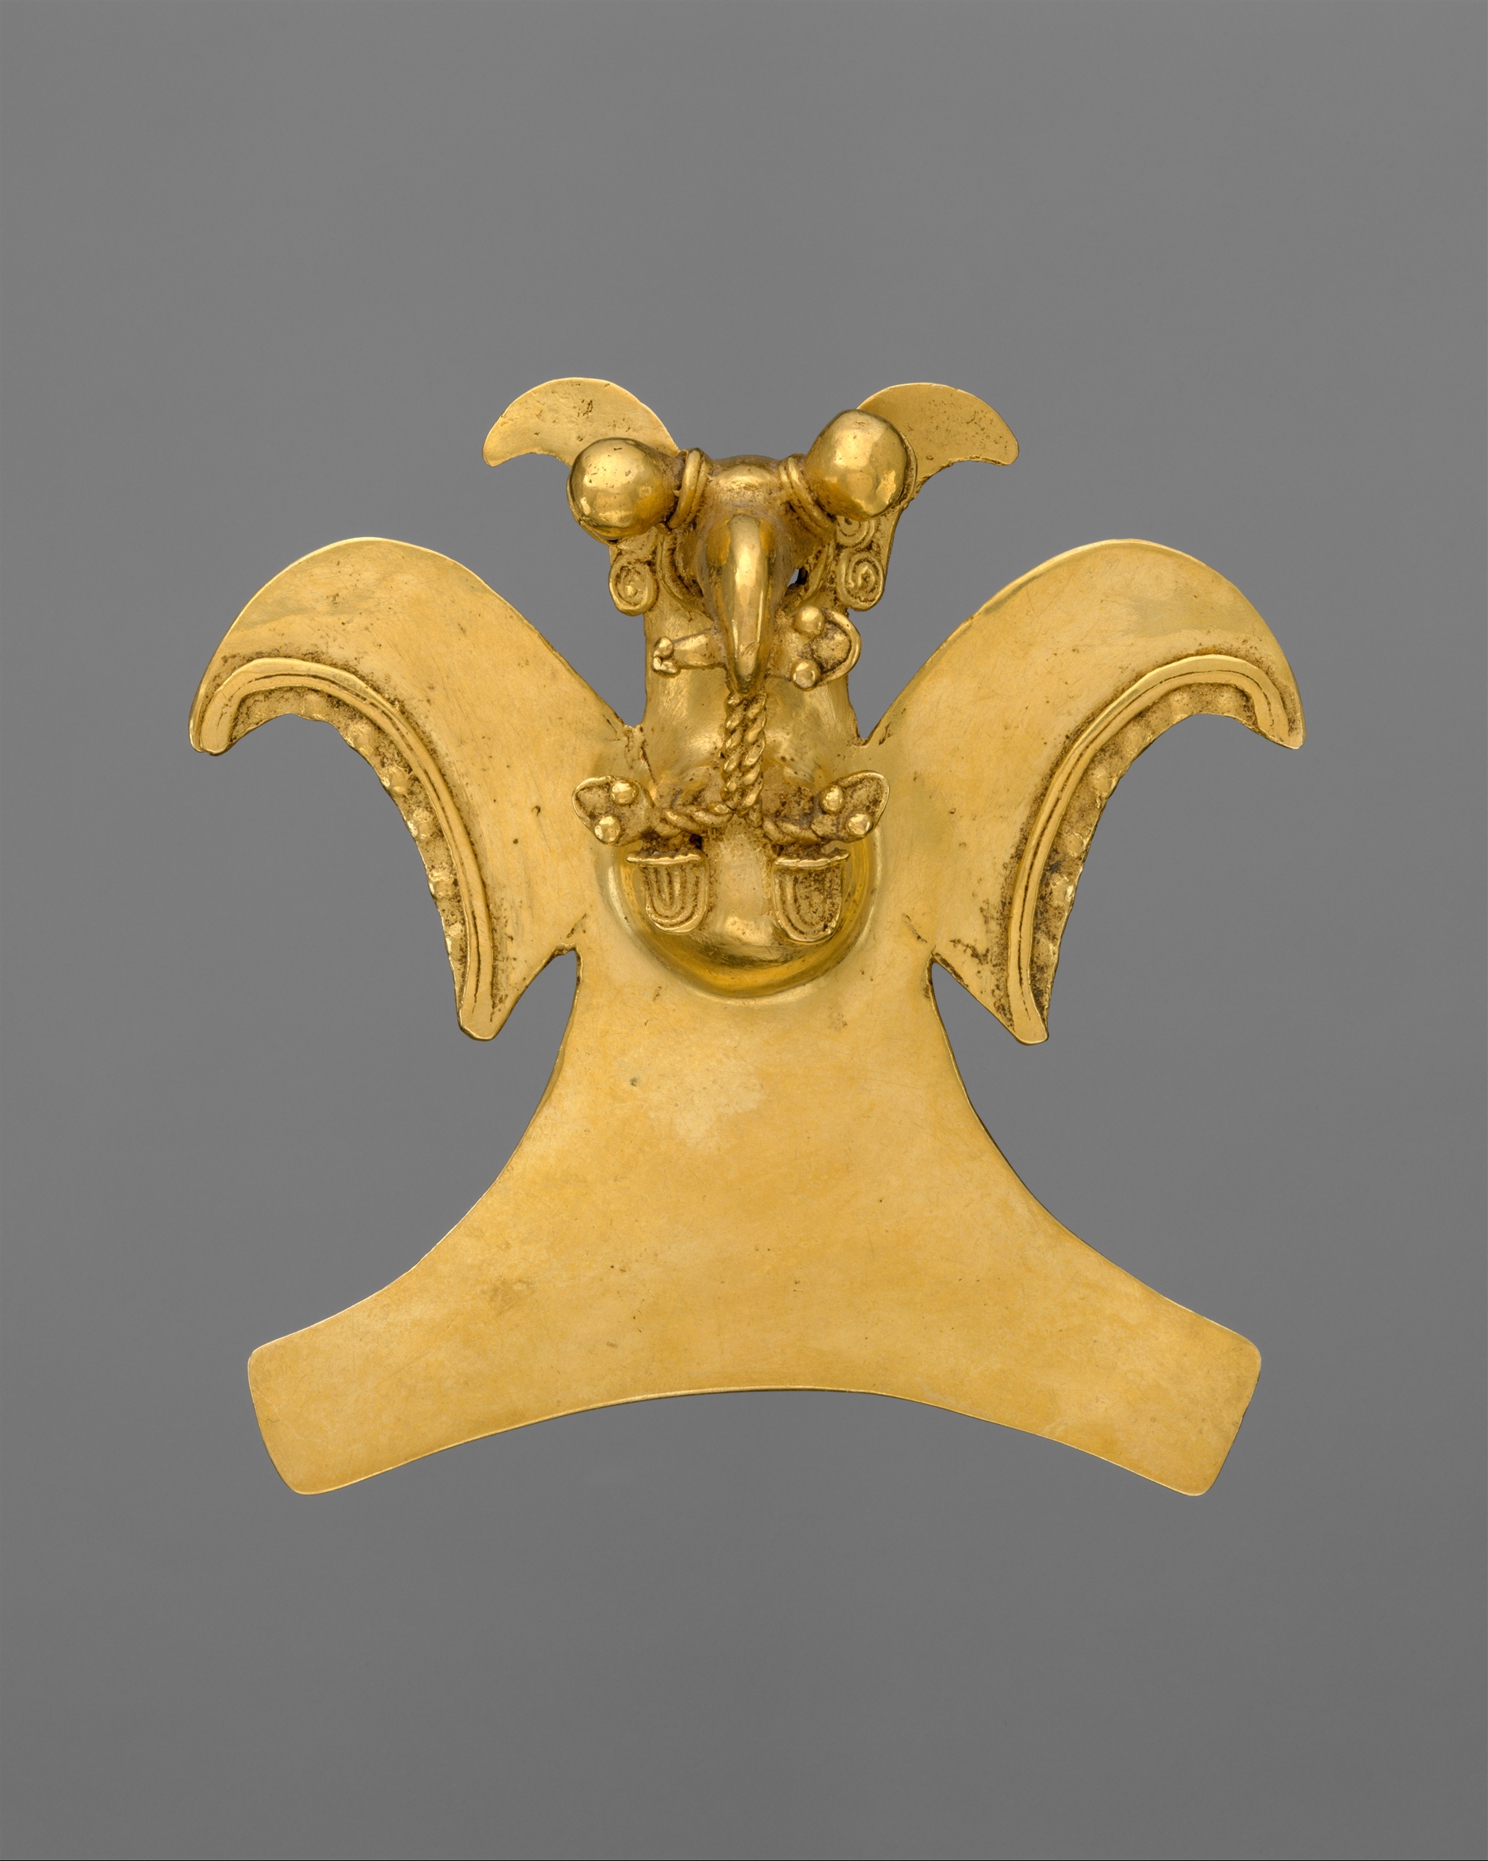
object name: pendant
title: Eagle pendant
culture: chiriquí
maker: chiriquí artist(s)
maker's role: artist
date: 800-1519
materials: gold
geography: costa rica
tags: eagles